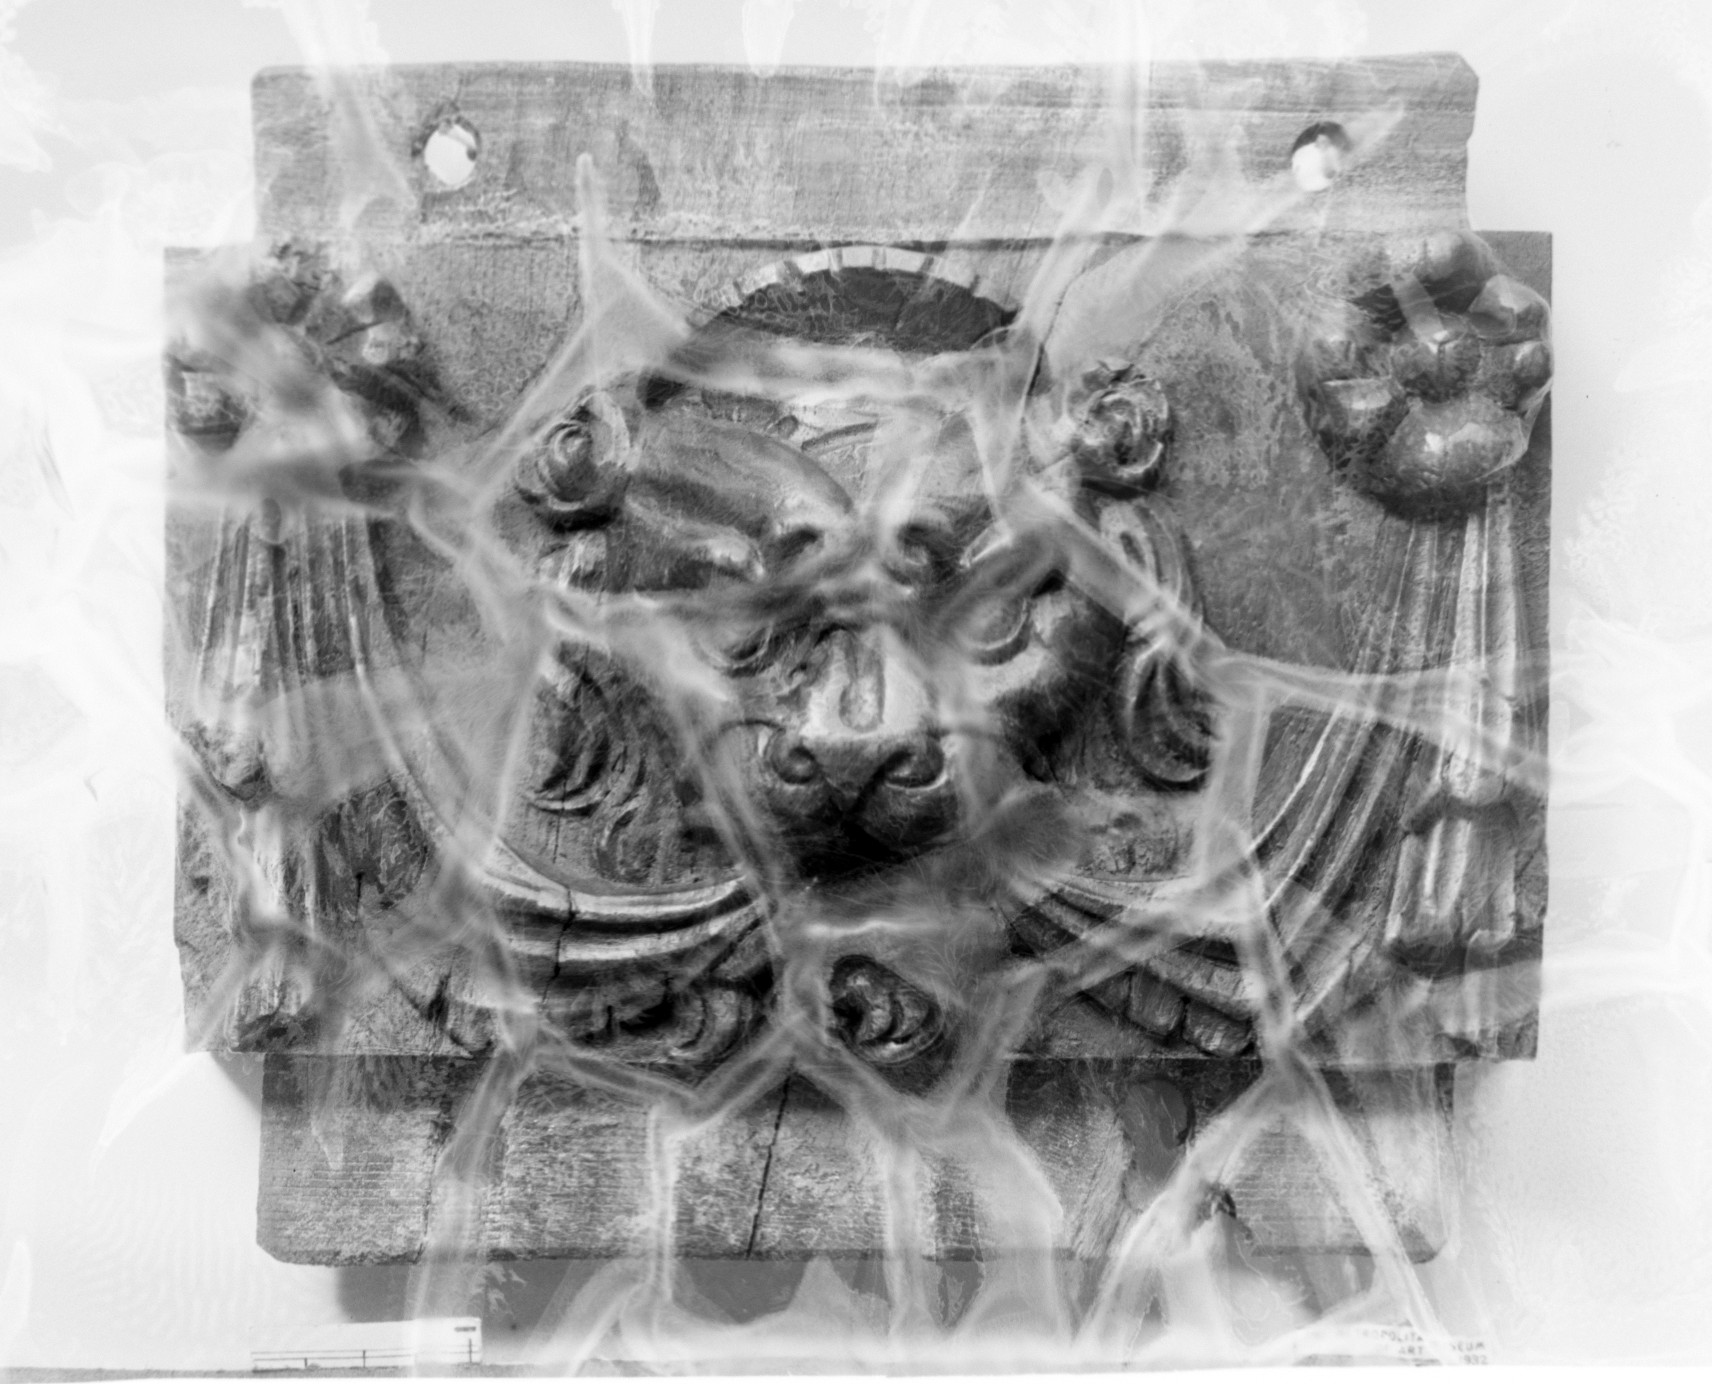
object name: panel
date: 1501-1600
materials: wood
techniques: carving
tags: lions